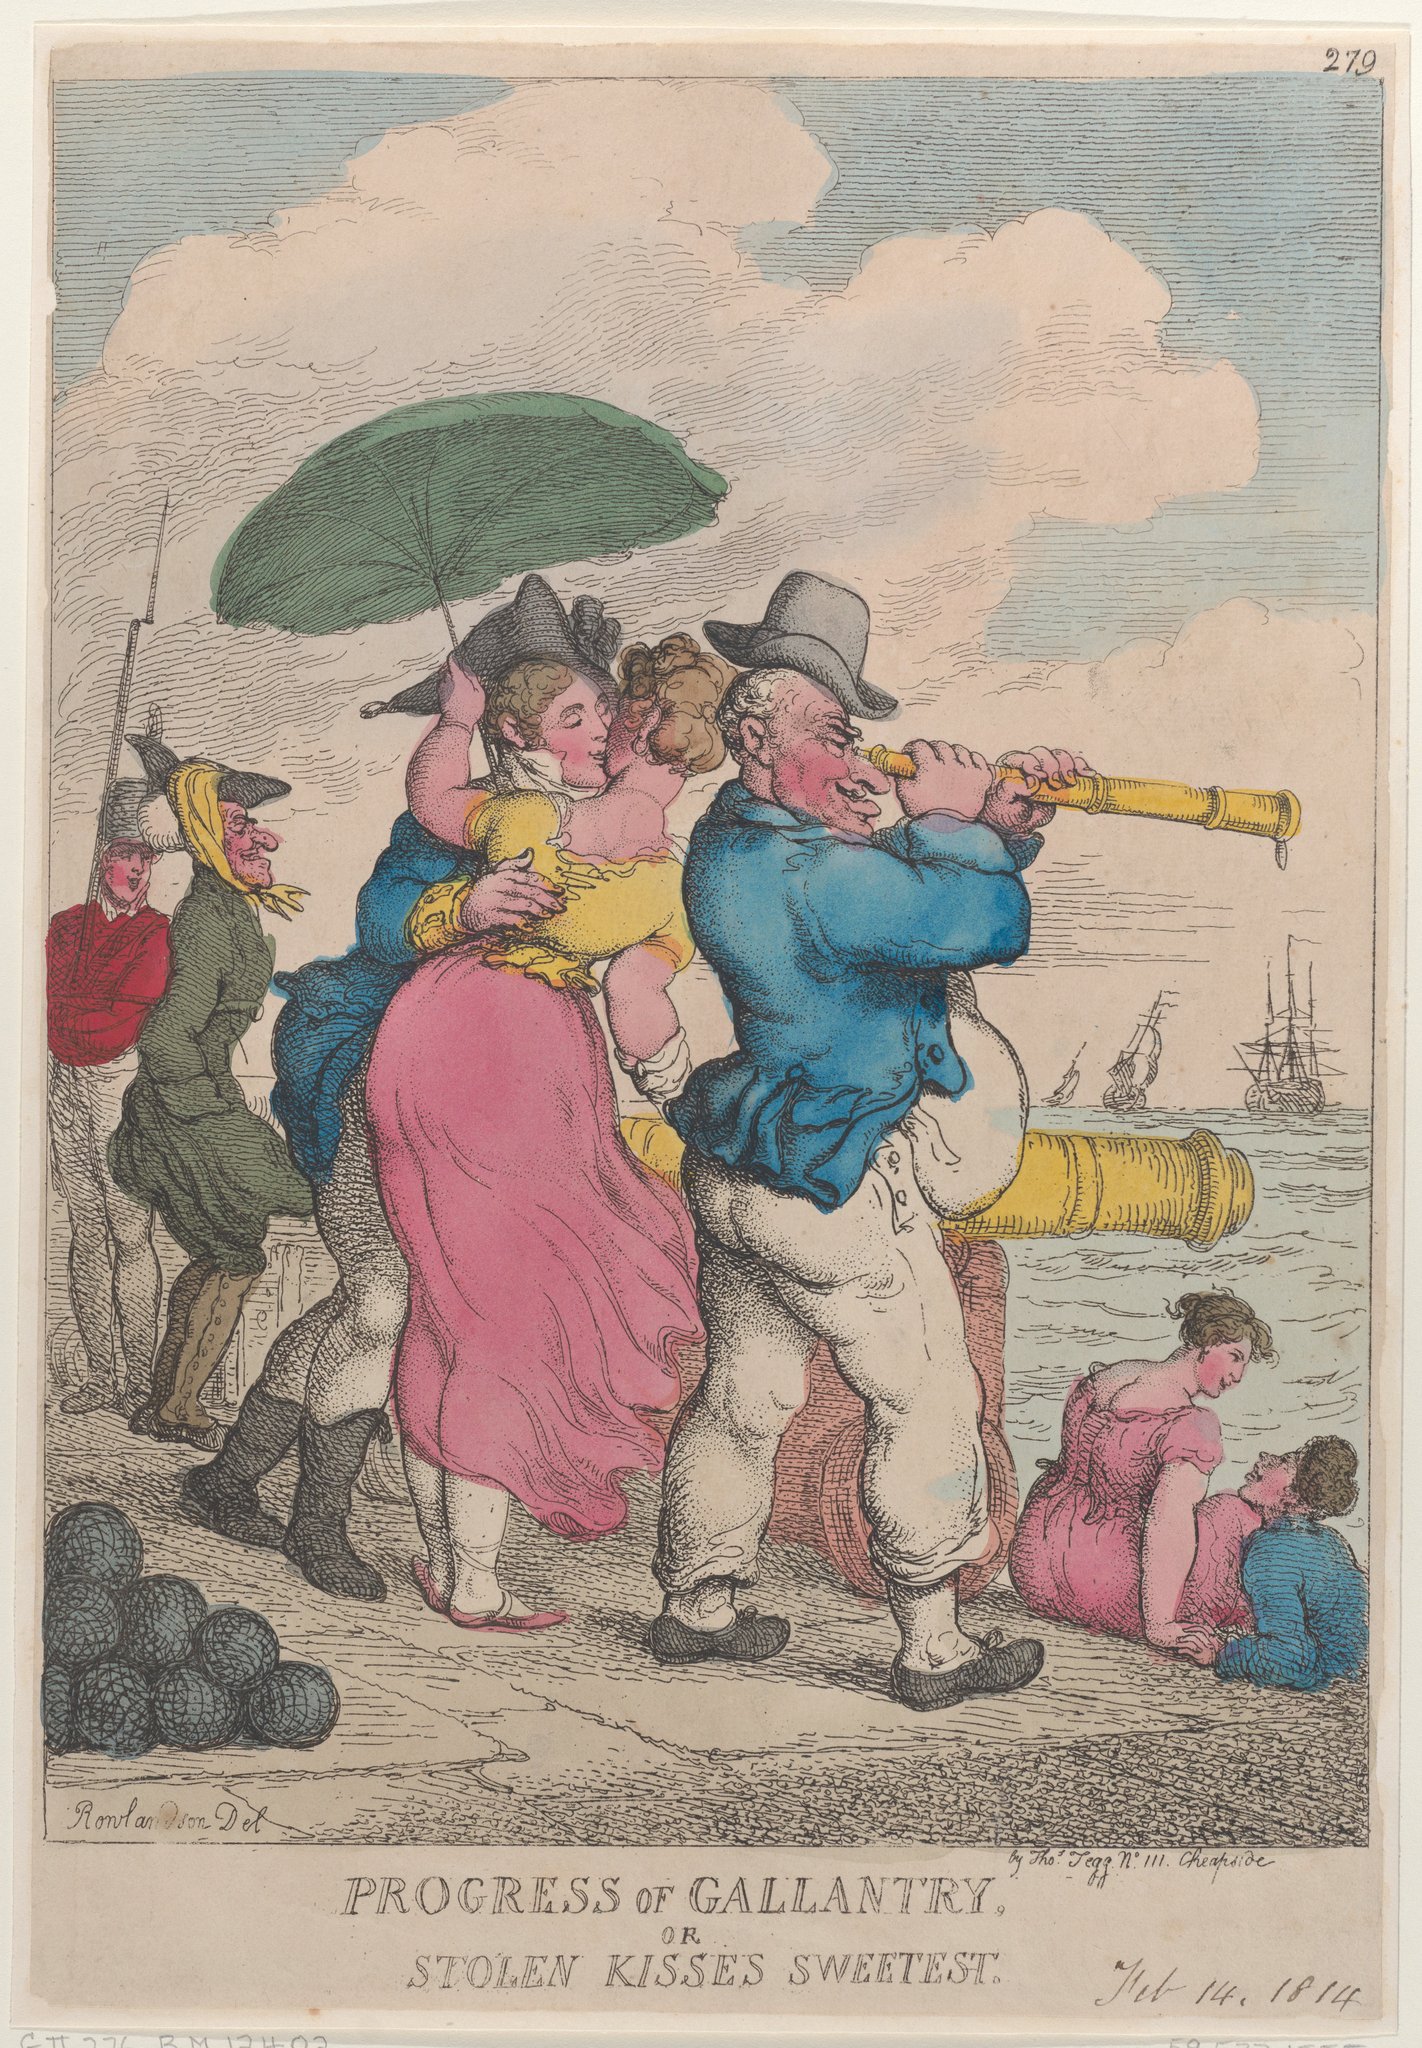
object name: print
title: Progress of Gallantry or Stolen Kisses Sweetest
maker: thomas rowlandson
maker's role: artist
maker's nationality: british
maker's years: 1757-1827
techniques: etching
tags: satire,couples,men,women,telescopes